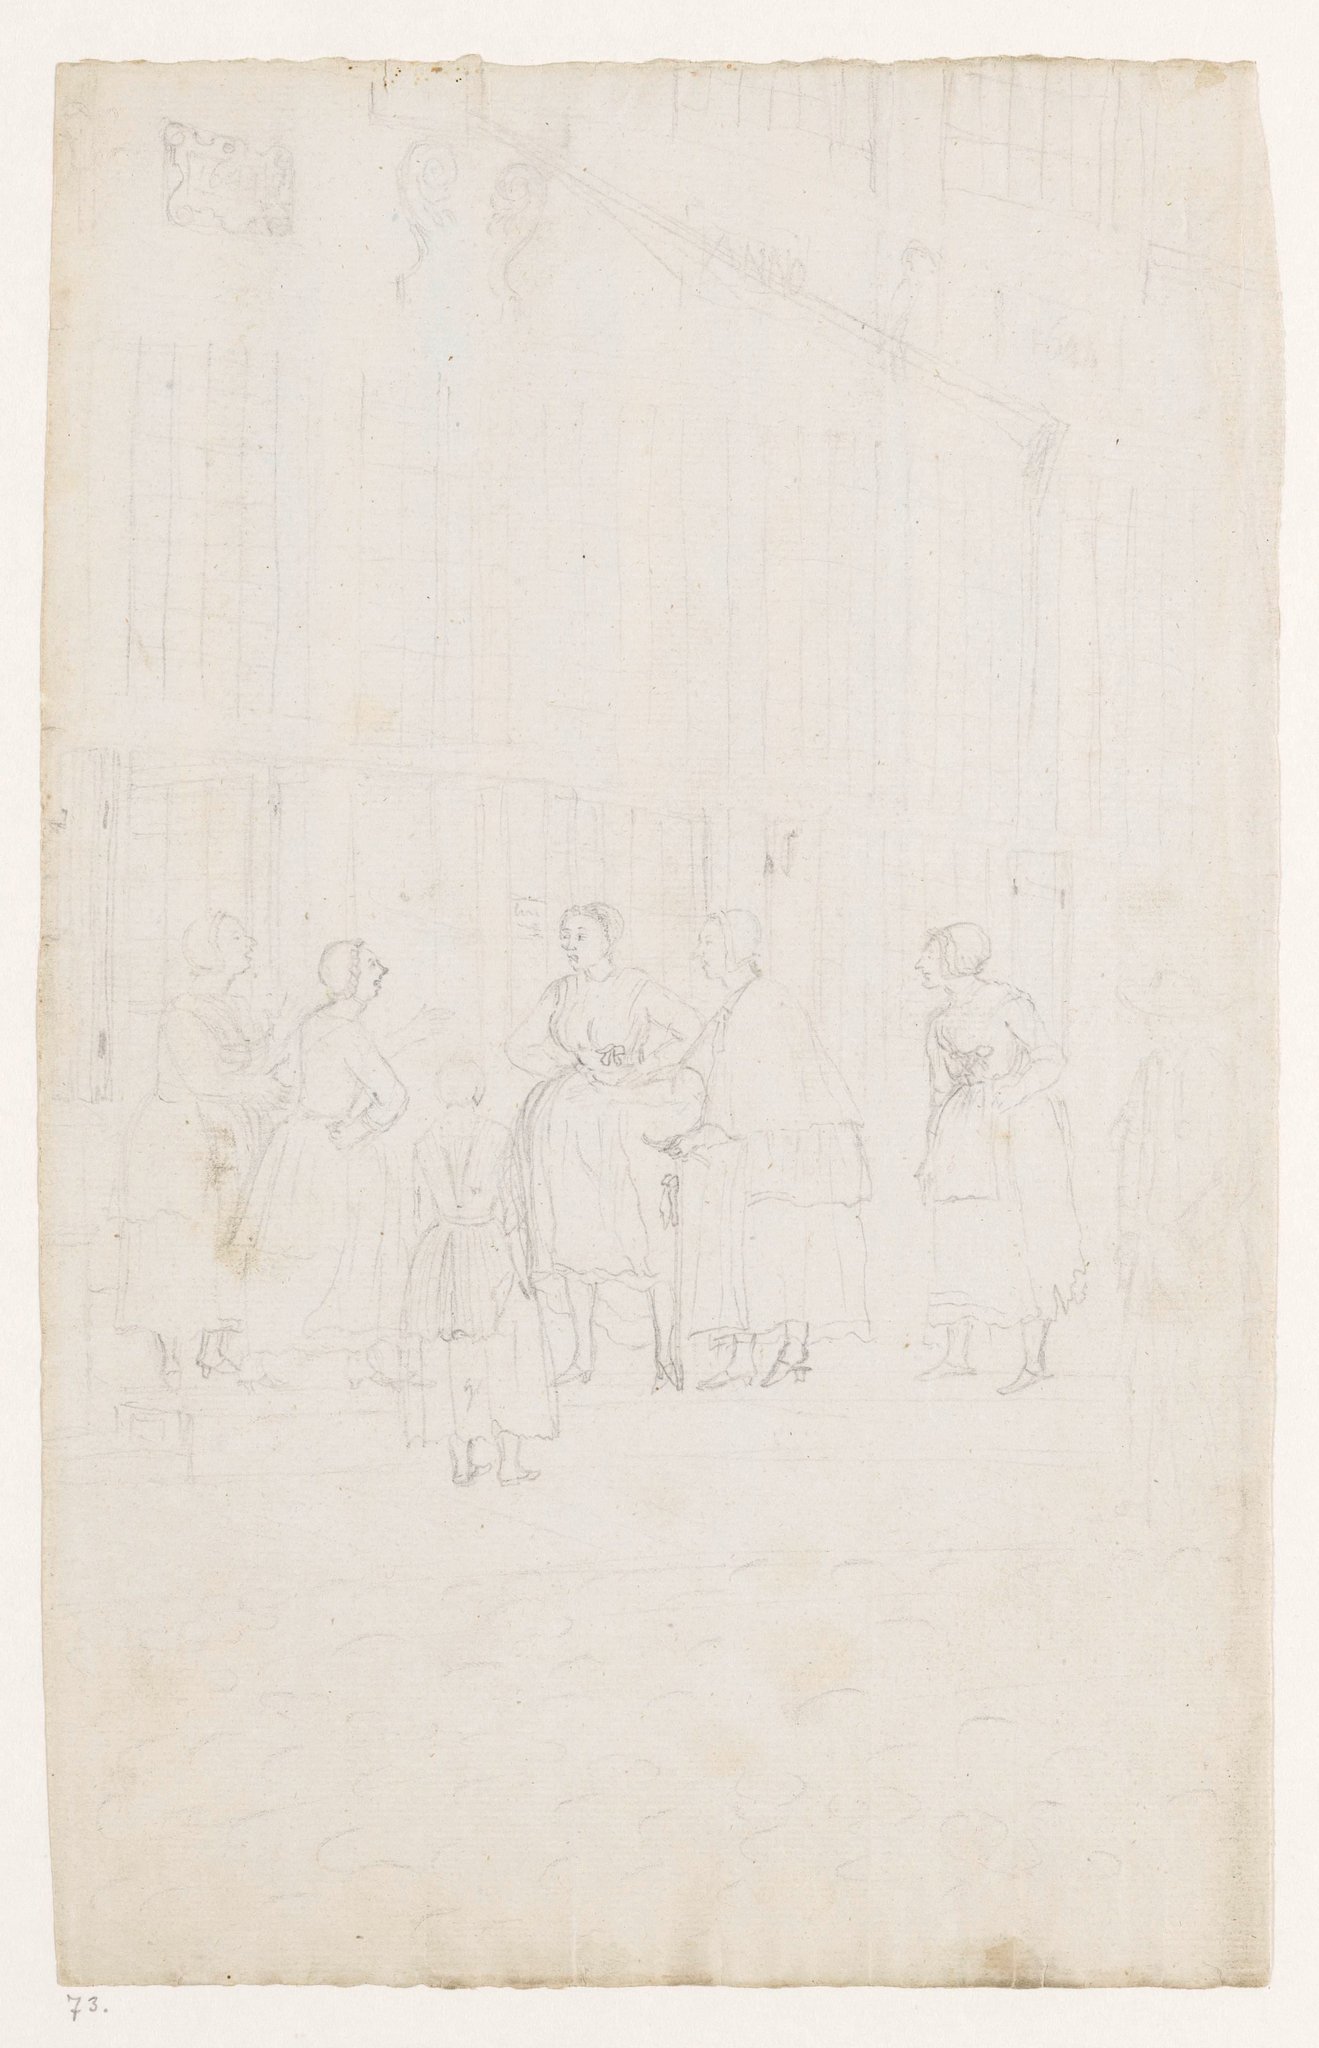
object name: drawing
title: Vrouwen op straat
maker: jan brandes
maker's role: draughtsman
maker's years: 1743-1808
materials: paper, pencil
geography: netherlands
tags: street (+ city(-scape) with figures, staffage), amsterdam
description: Een aantal vrouwen met hoofddoeken en wijde rokken staan met de handen in de zij te praten of ruzie te maken. De achtergrond is een rij huizen met een gevelsteen 1644. Waarschijnlijk Amsterdam.